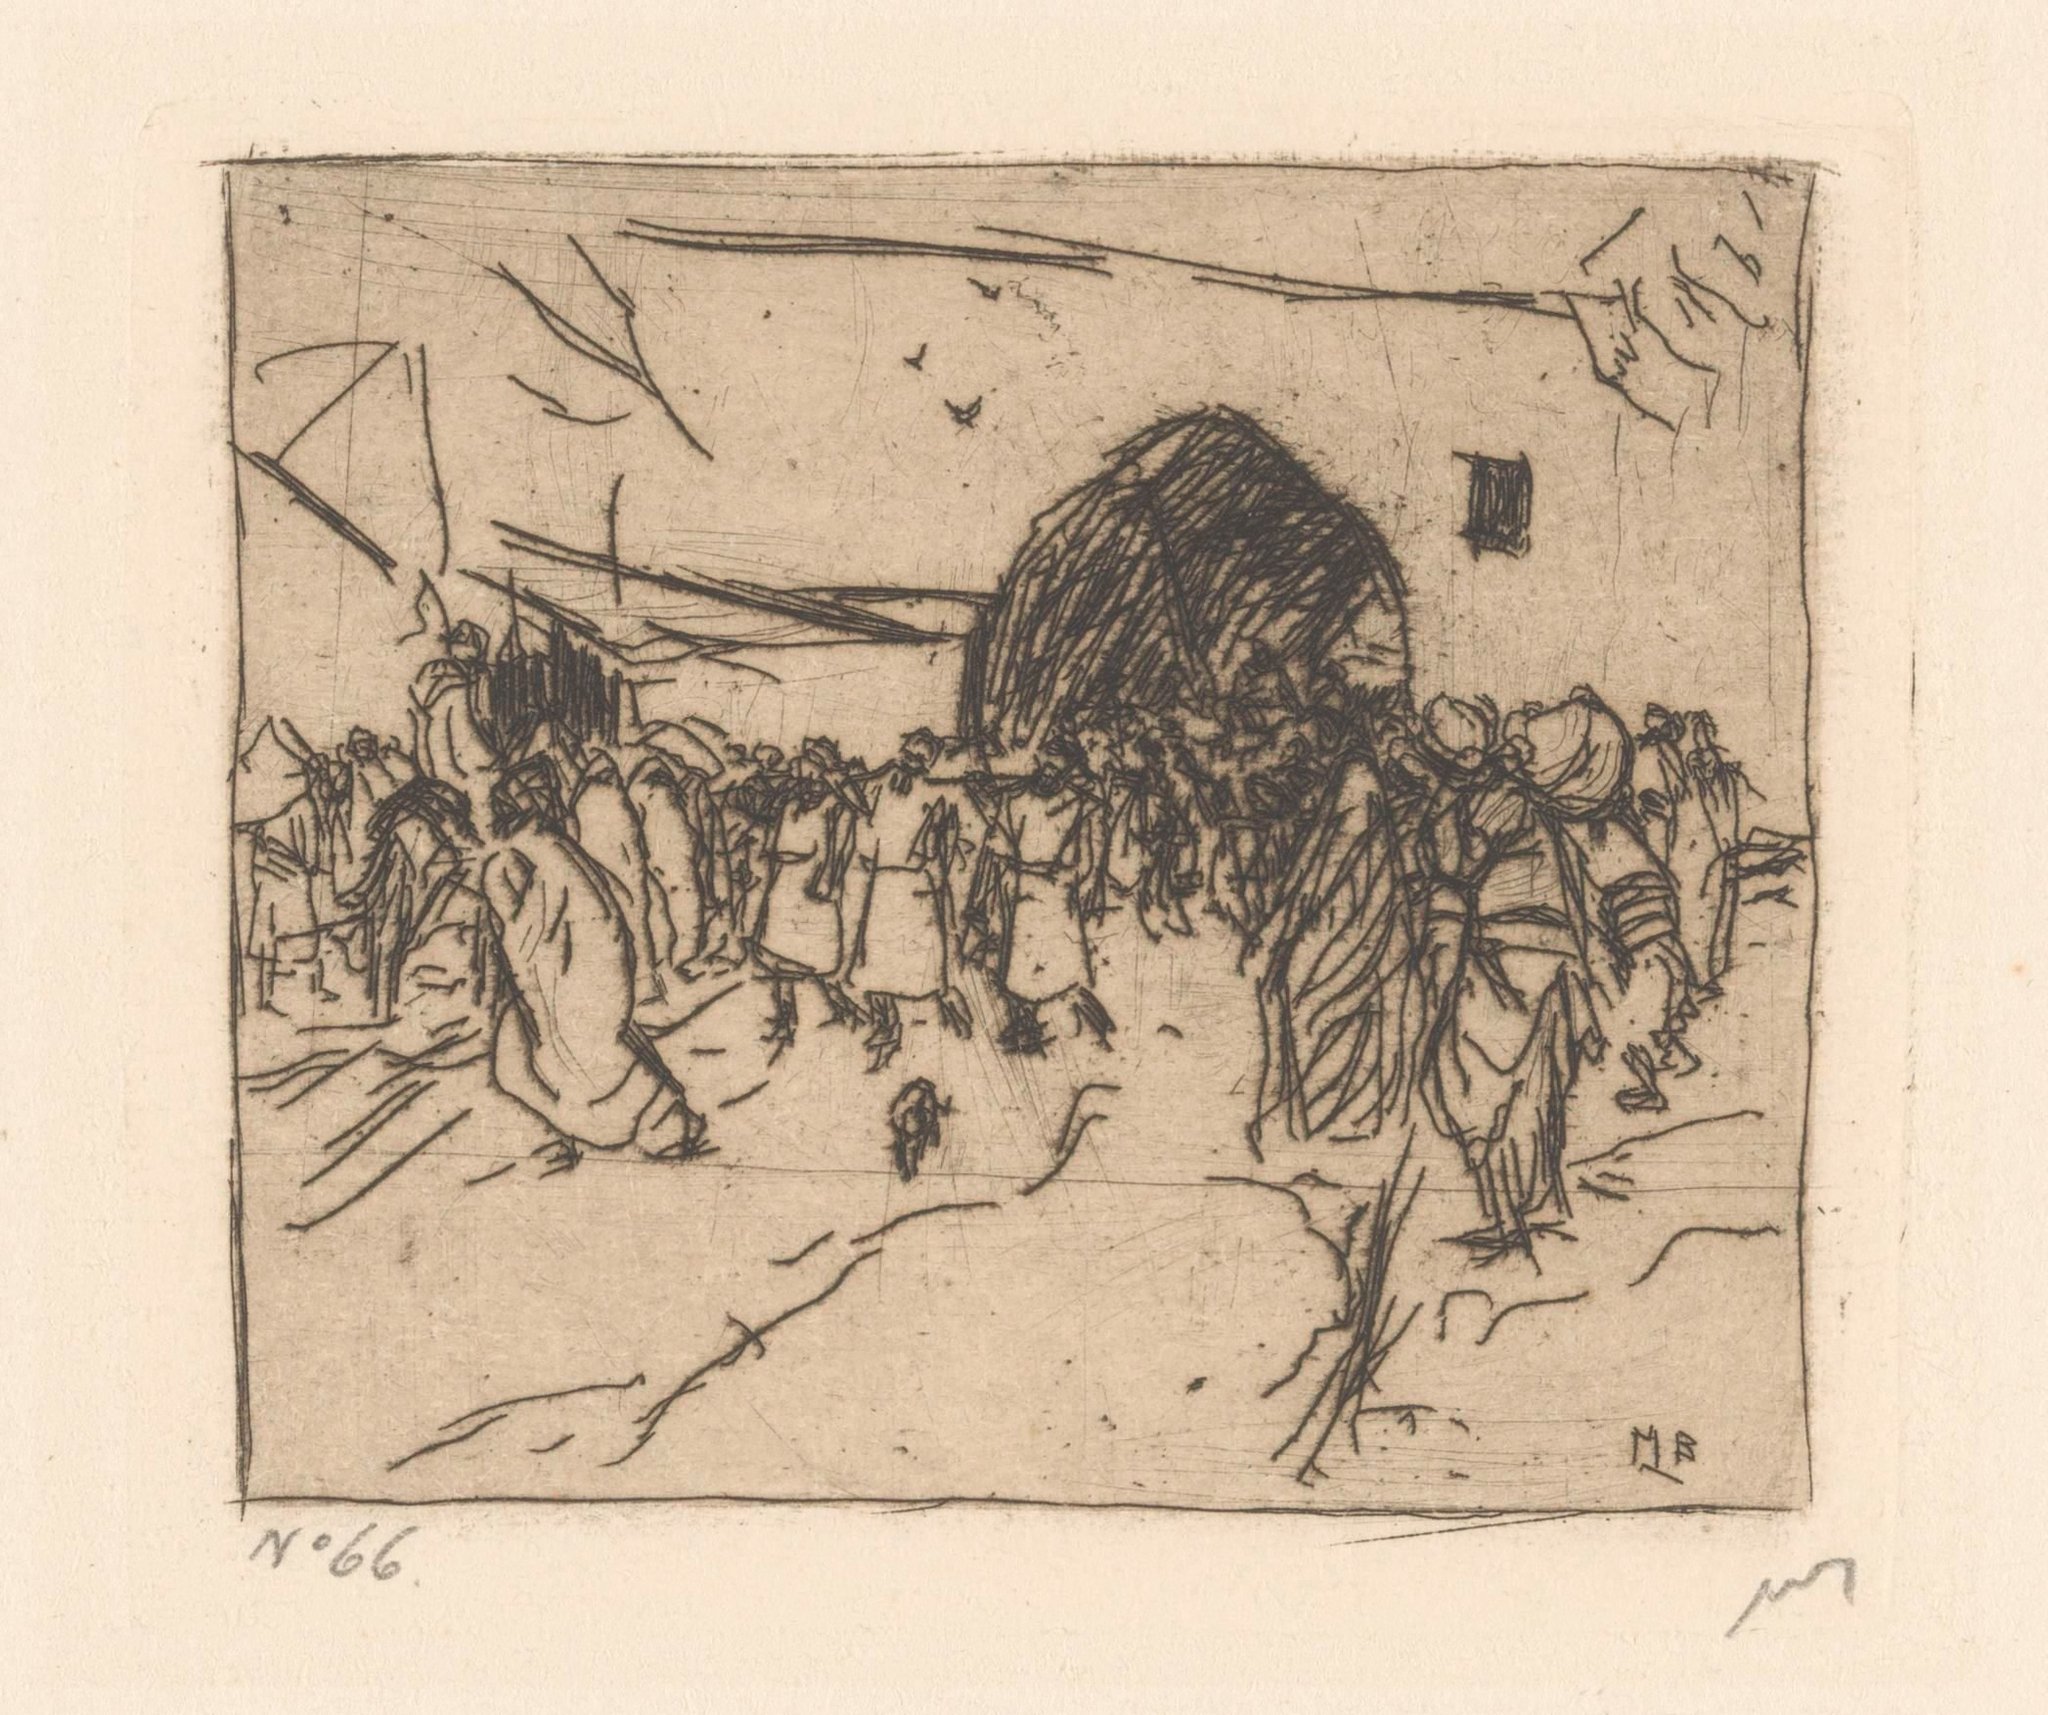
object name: print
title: Poort in Constantinopel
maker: marius bauer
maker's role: draughtsman, print maker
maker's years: 1867-1932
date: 1889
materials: paper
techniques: etching, intaglio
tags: city-gate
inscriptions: collector's mark: Lugt 2228, collector's mark: Lugt 2760